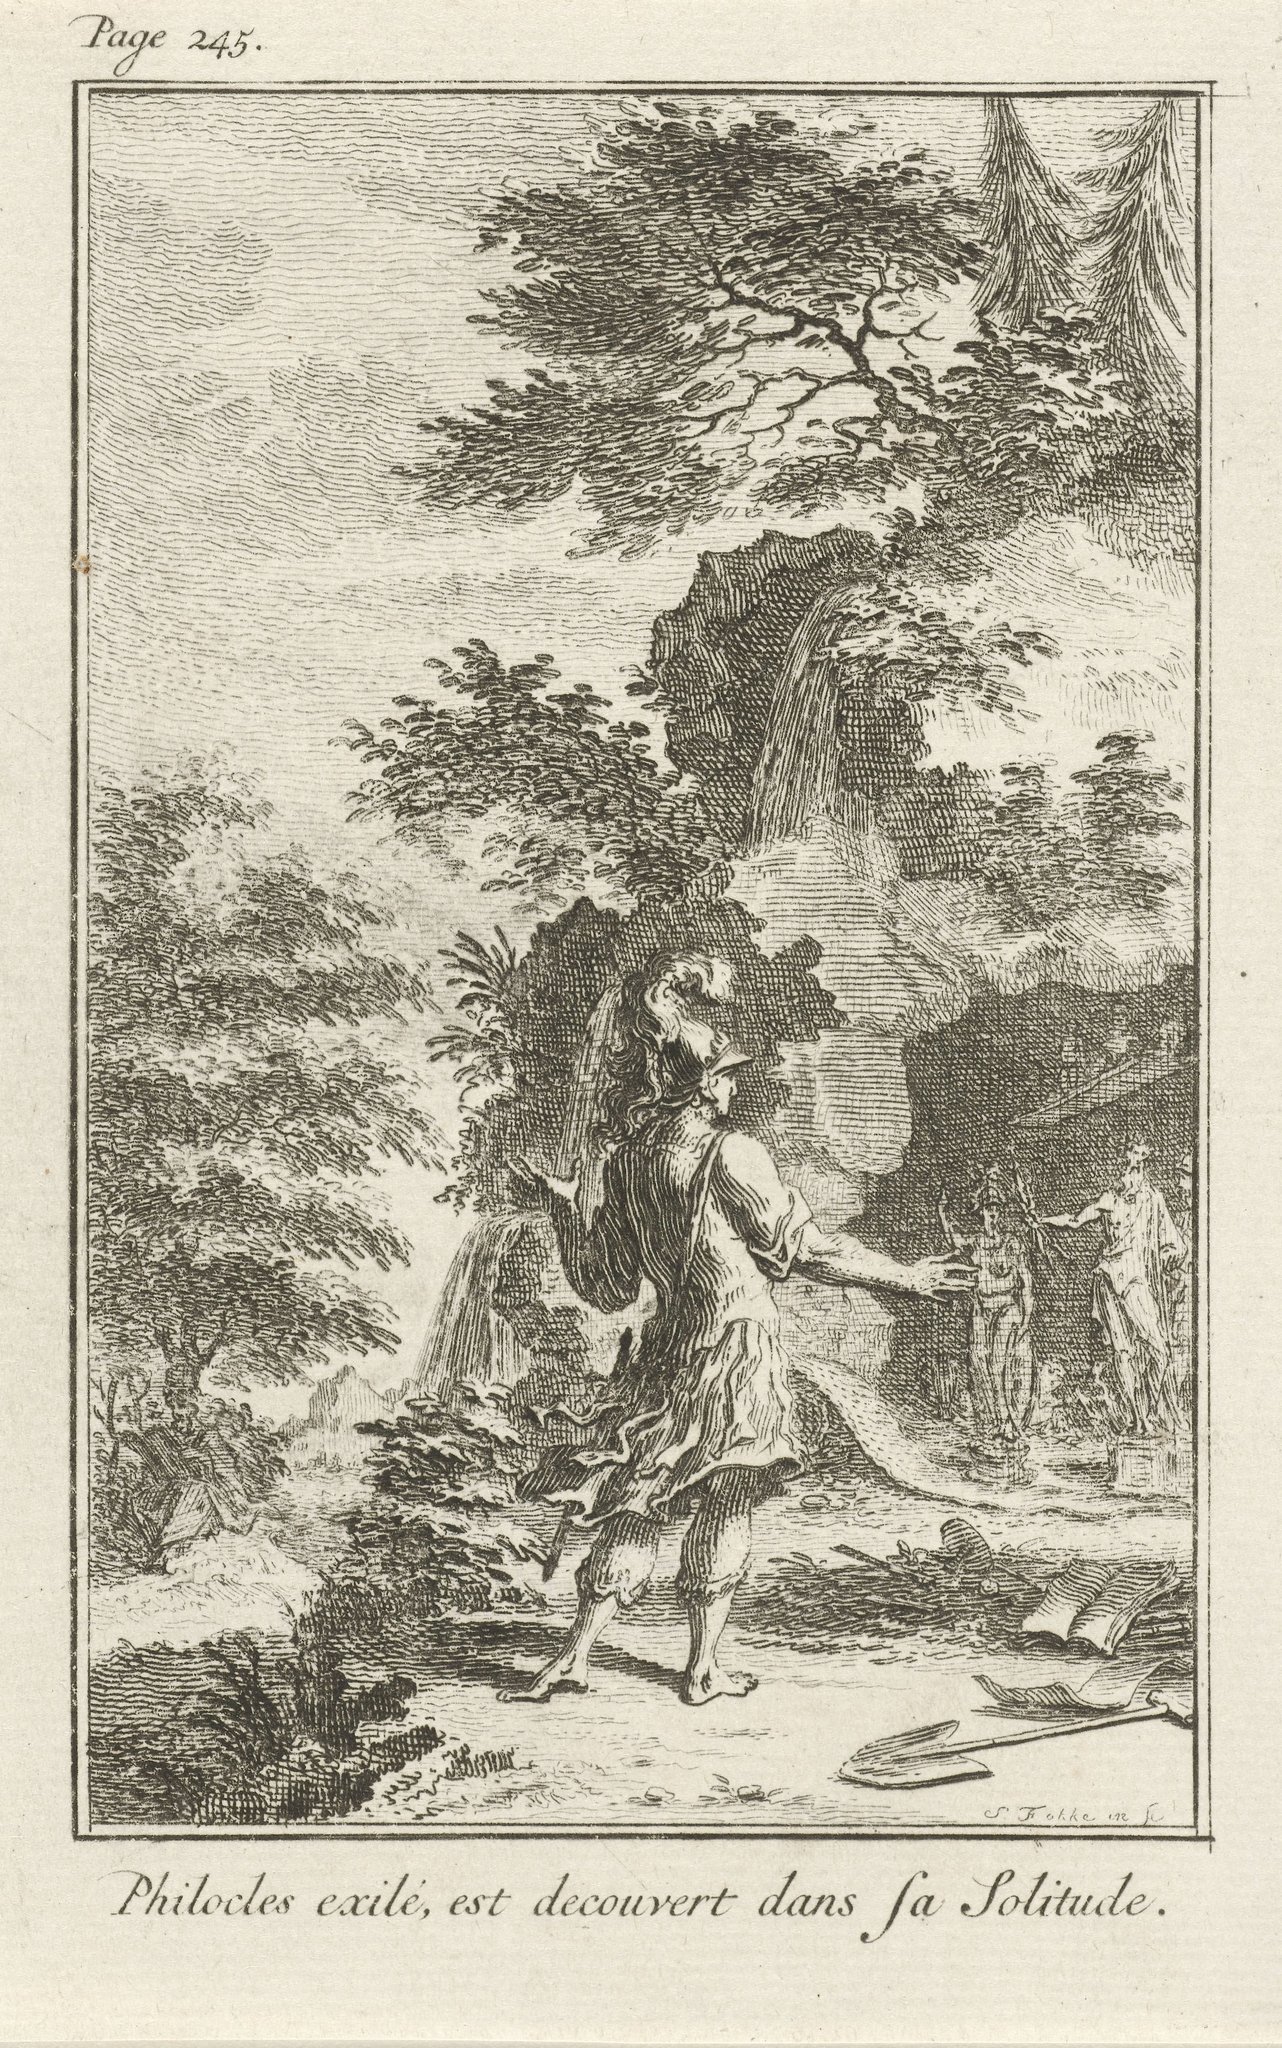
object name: print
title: Telemachus ontdekt Philocles in een grot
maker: simon fokke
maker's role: draughtsman, print maker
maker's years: 1712-1784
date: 1775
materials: paper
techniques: etching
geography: amsterdam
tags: cave, grotto, (story of) telemachus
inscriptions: collector's mark: Lugt 2228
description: Illustratie uit: Fénélon, François de Salignac de la Mothe. Les avantures de Telemaque, fils d’Ulysse. Amsterdam: Evert van Harrevelt, 1775.